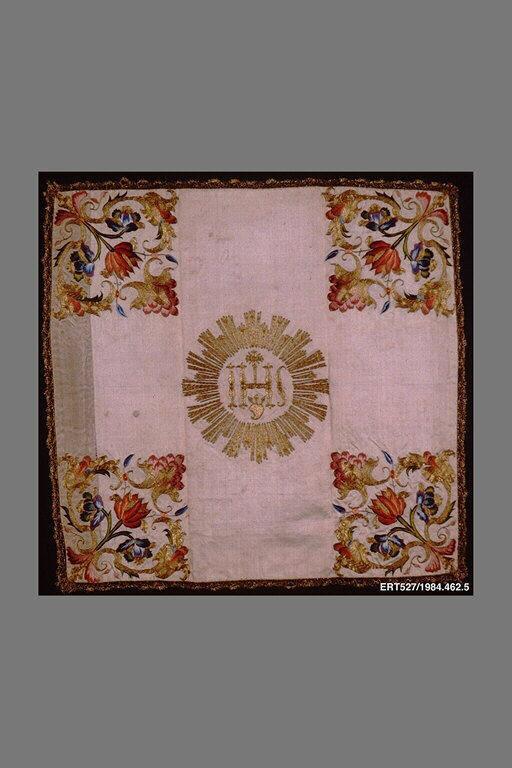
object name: chalice cover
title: Chalice veil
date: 1701-1800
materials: metal thread, silk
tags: flowers